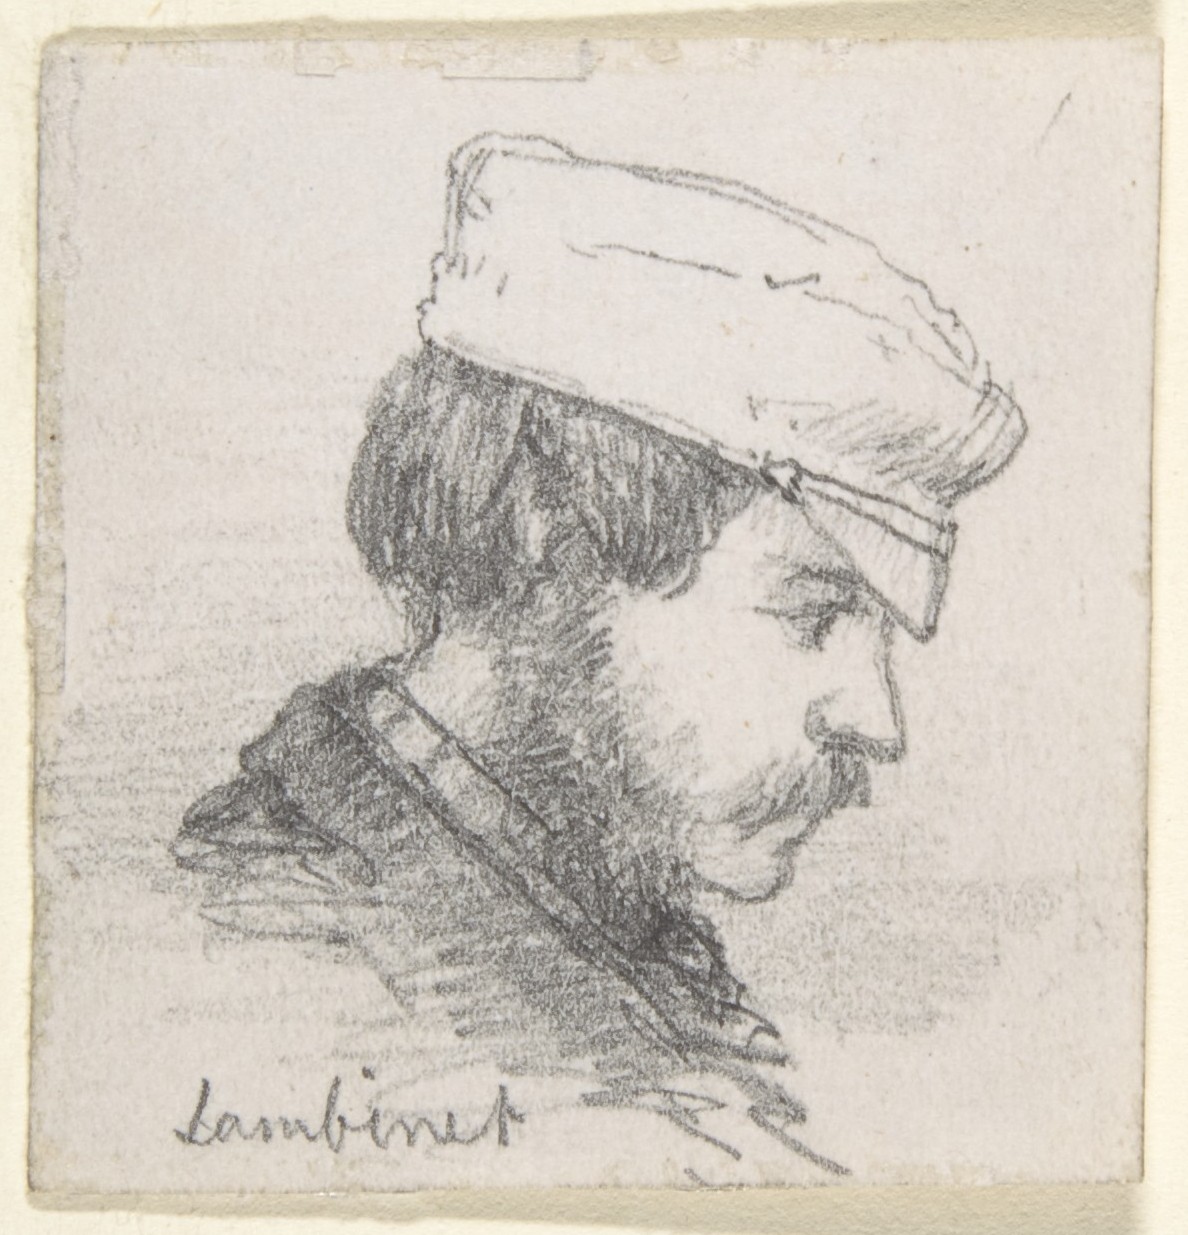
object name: drawing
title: Portrait of Lambinet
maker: anonymous, french, 19th century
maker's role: artist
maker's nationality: french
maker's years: 1800-1900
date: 1801-1900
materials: graphite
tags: men,portraits